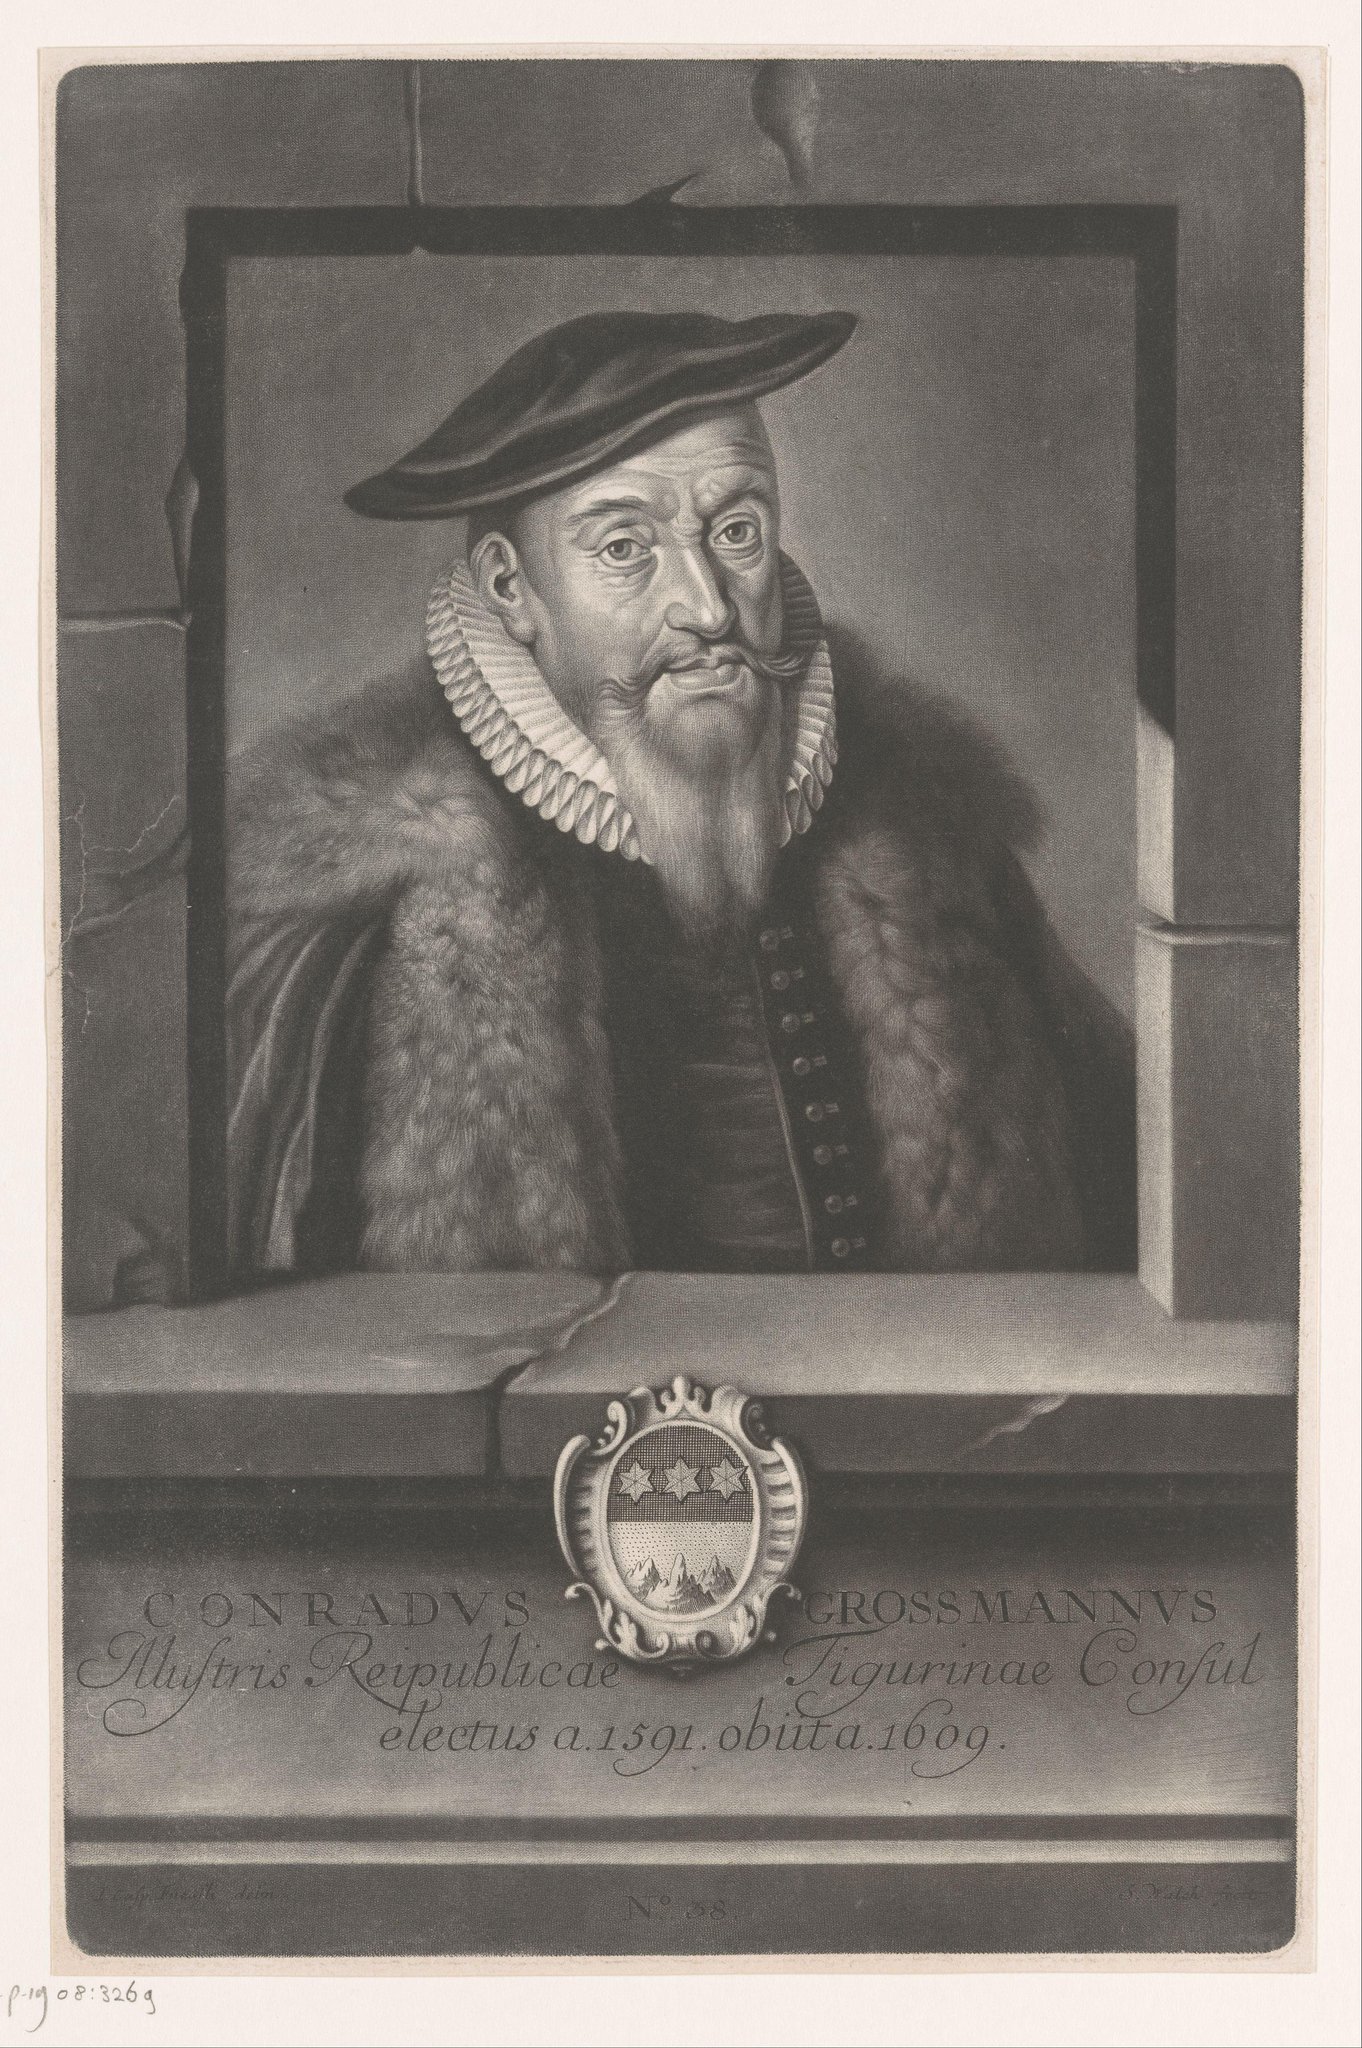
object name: print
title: Portret van Conrad Grossmann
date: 1731-1788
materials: paper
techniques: mezzotint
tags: mayor, historical persons, armorial bearing, heraldry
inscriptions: collector's mark: Lugt 2228